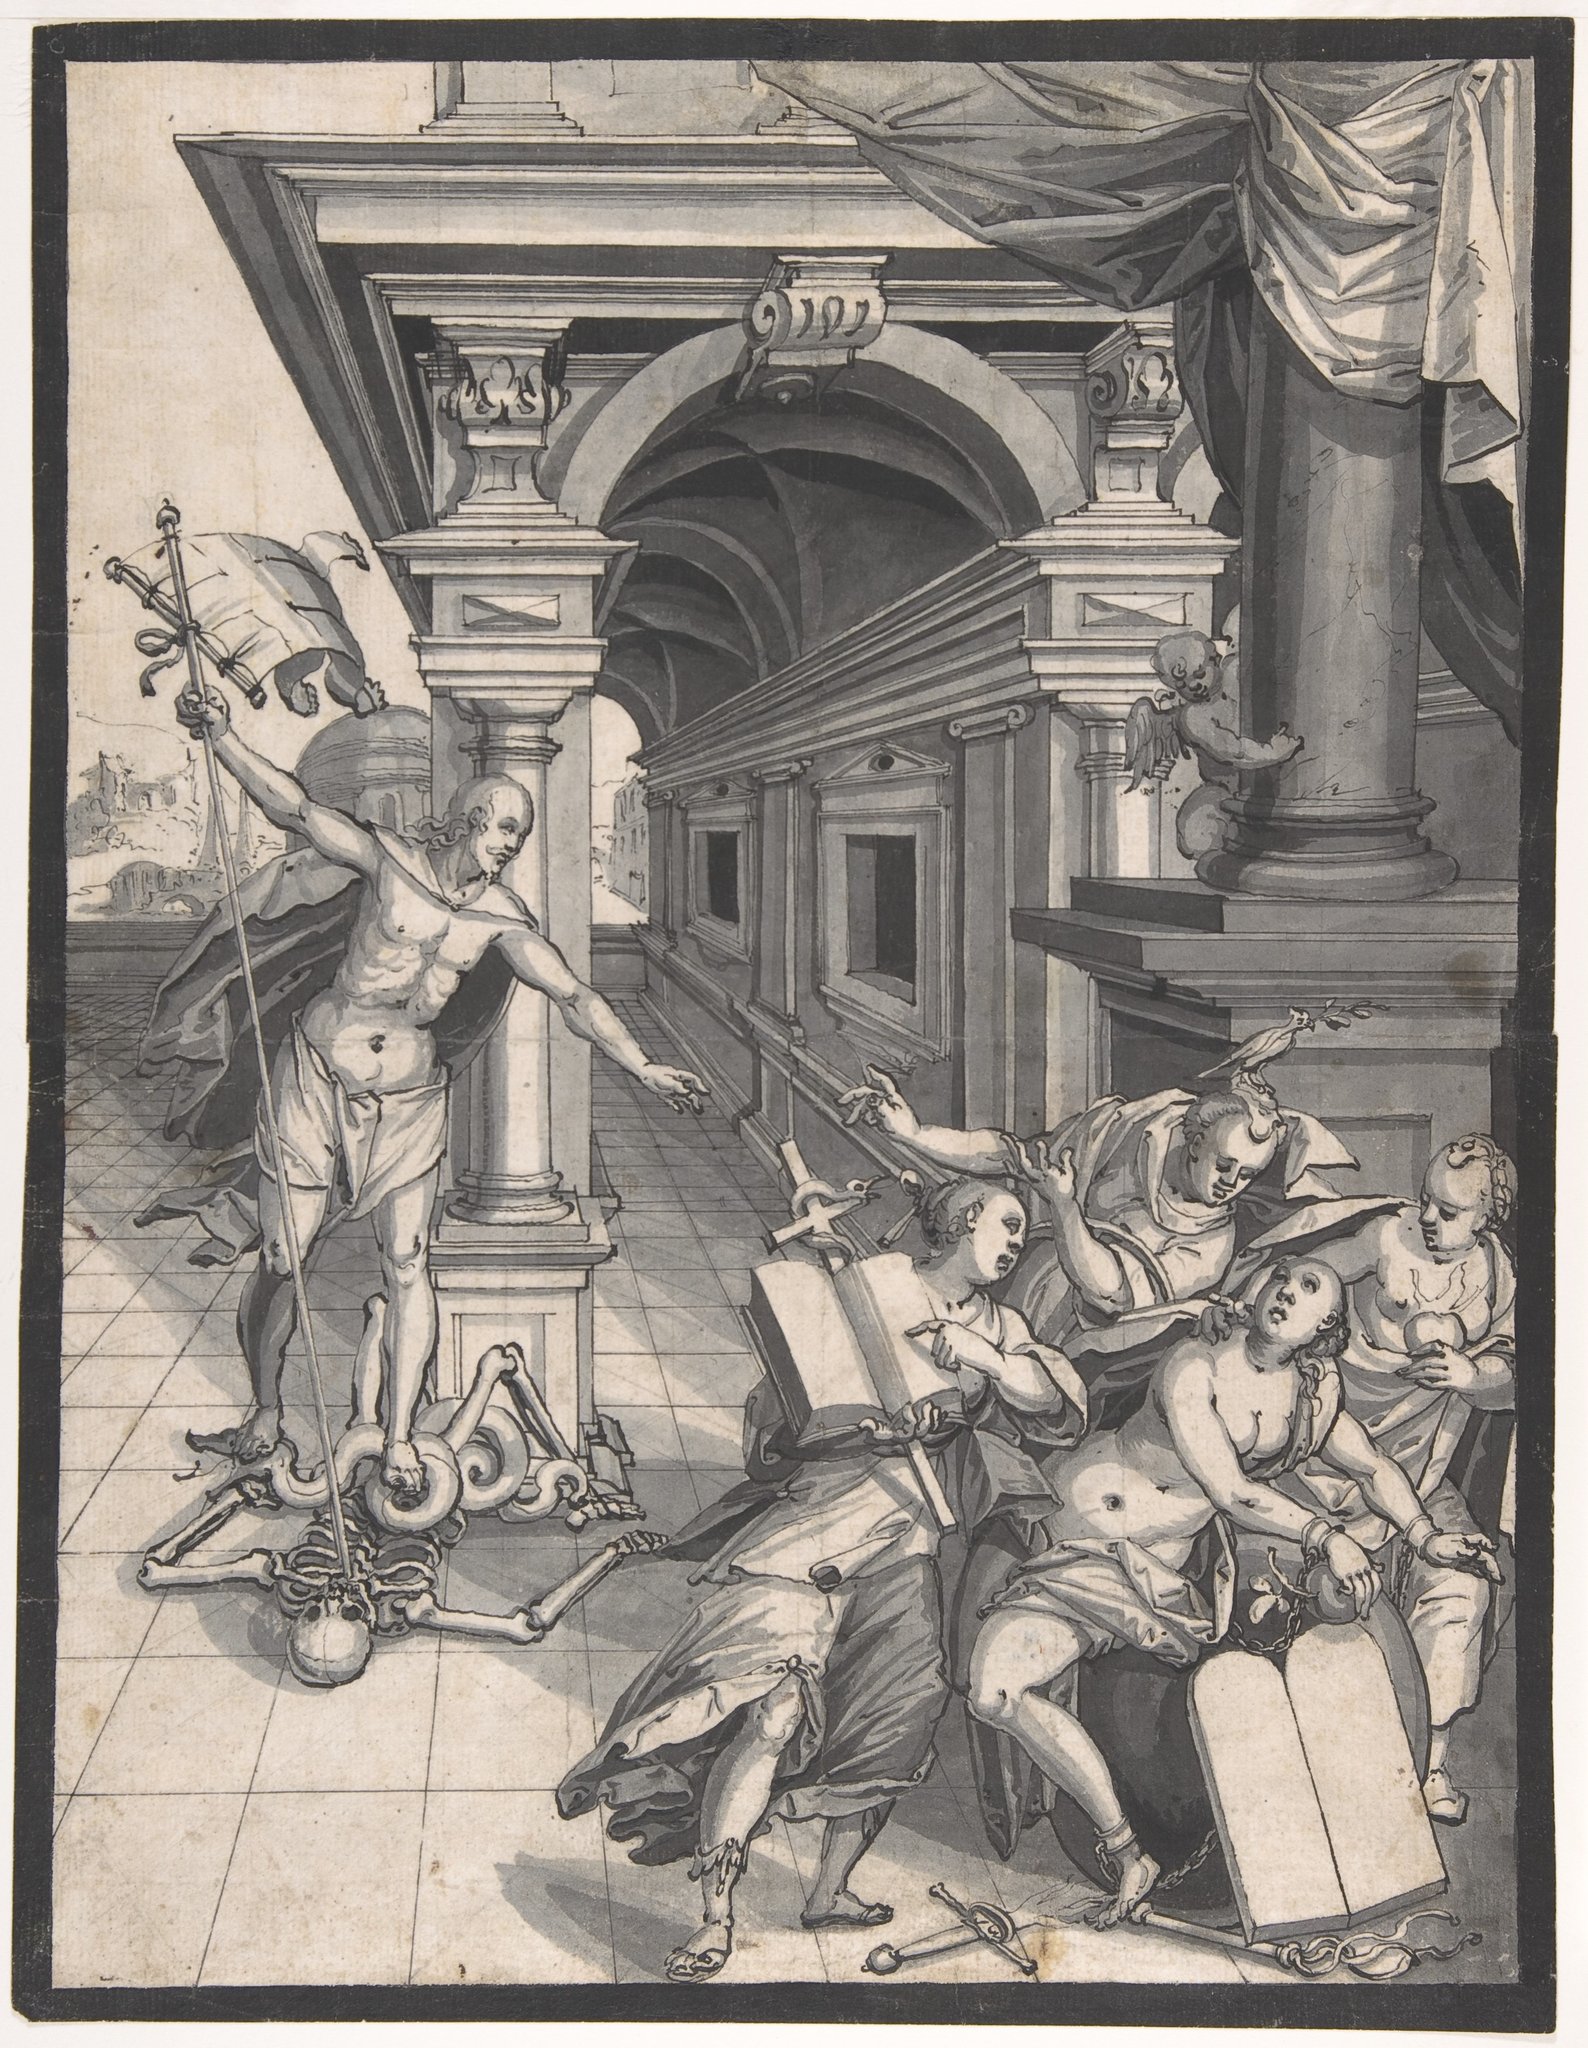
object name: drawing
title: Christ Saving Eve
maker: hans jakob nüscheler the elder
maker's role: artist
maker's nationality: swiss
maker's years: 1583-1654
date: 1595-1654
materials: ink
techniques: brush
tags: skeletons,women,christ,eve